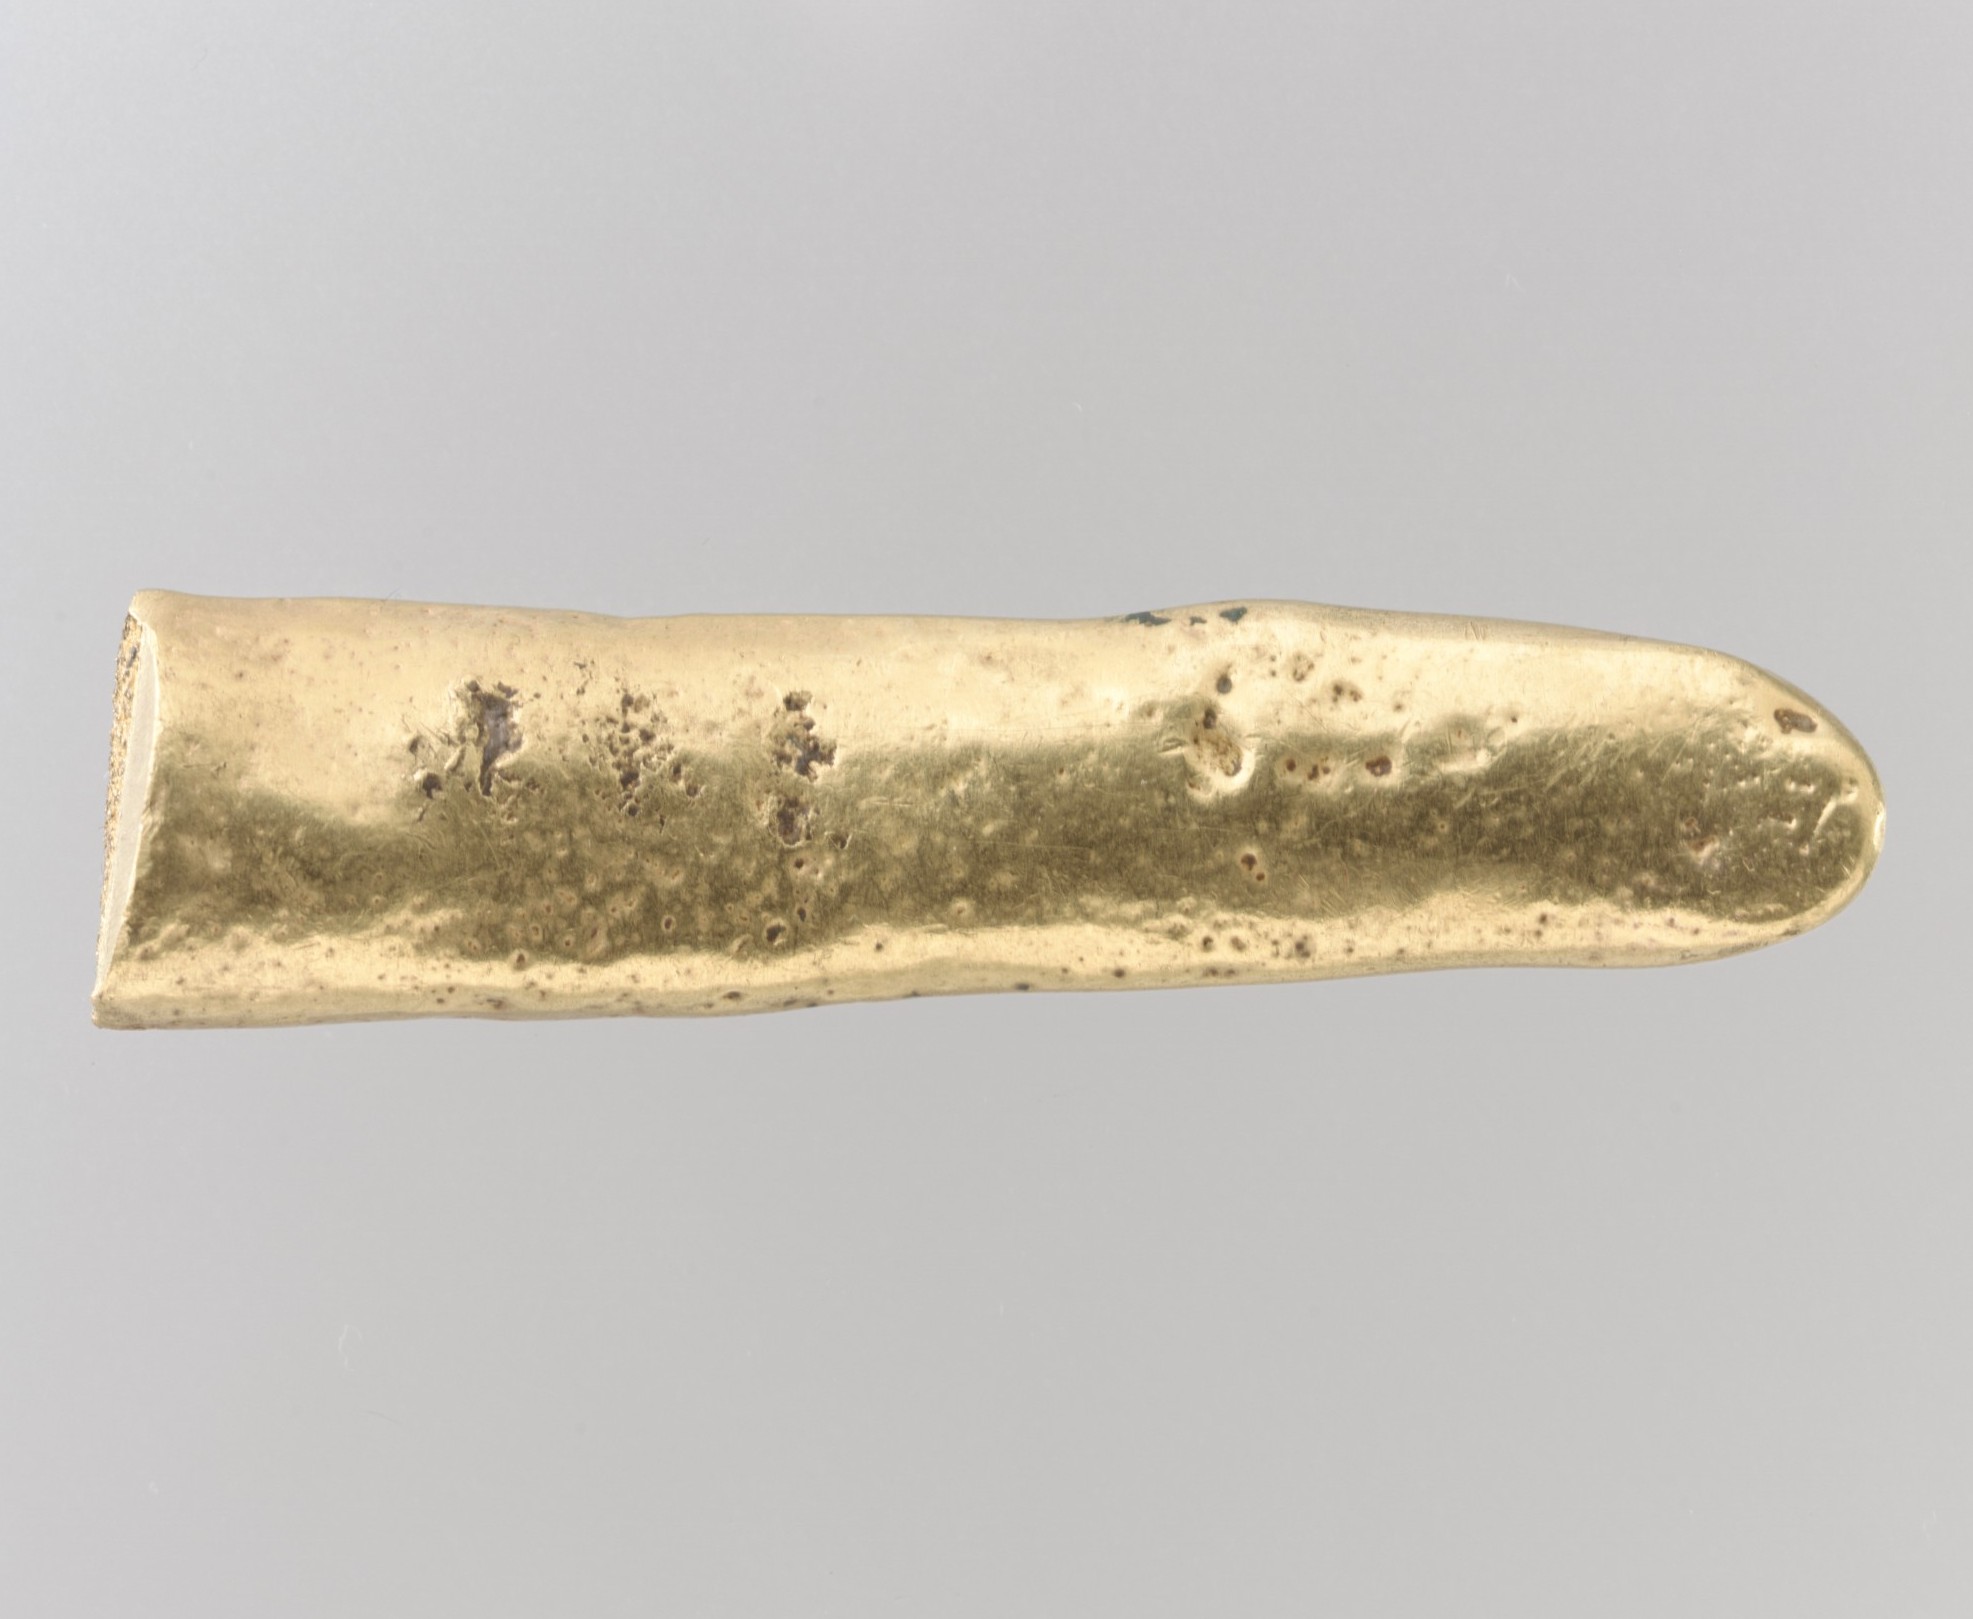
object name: ingot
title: Fragment of a Gold Ingot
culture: avar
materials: gold